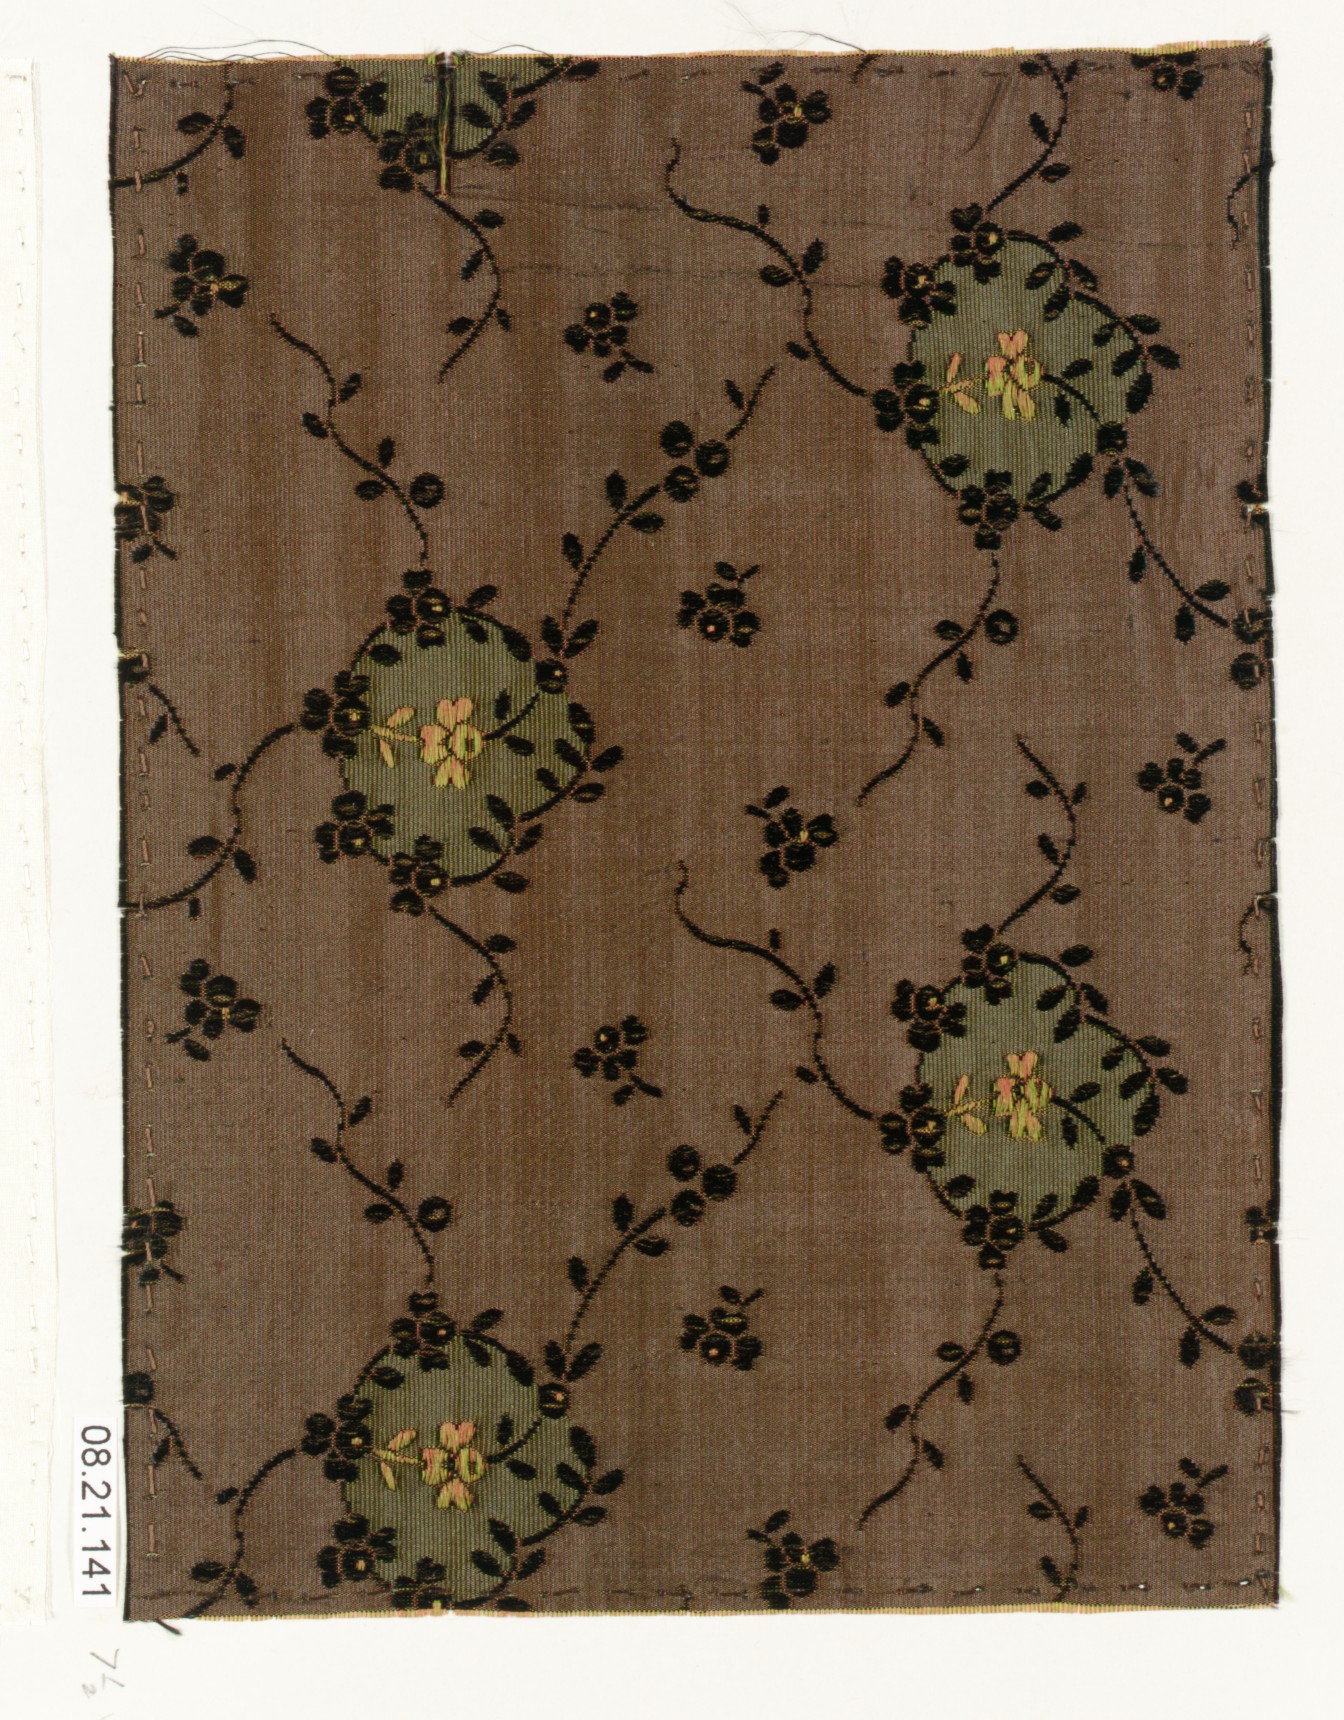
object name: textile sample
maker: Anonymous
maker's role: designer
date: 1900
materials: silk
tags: flowers